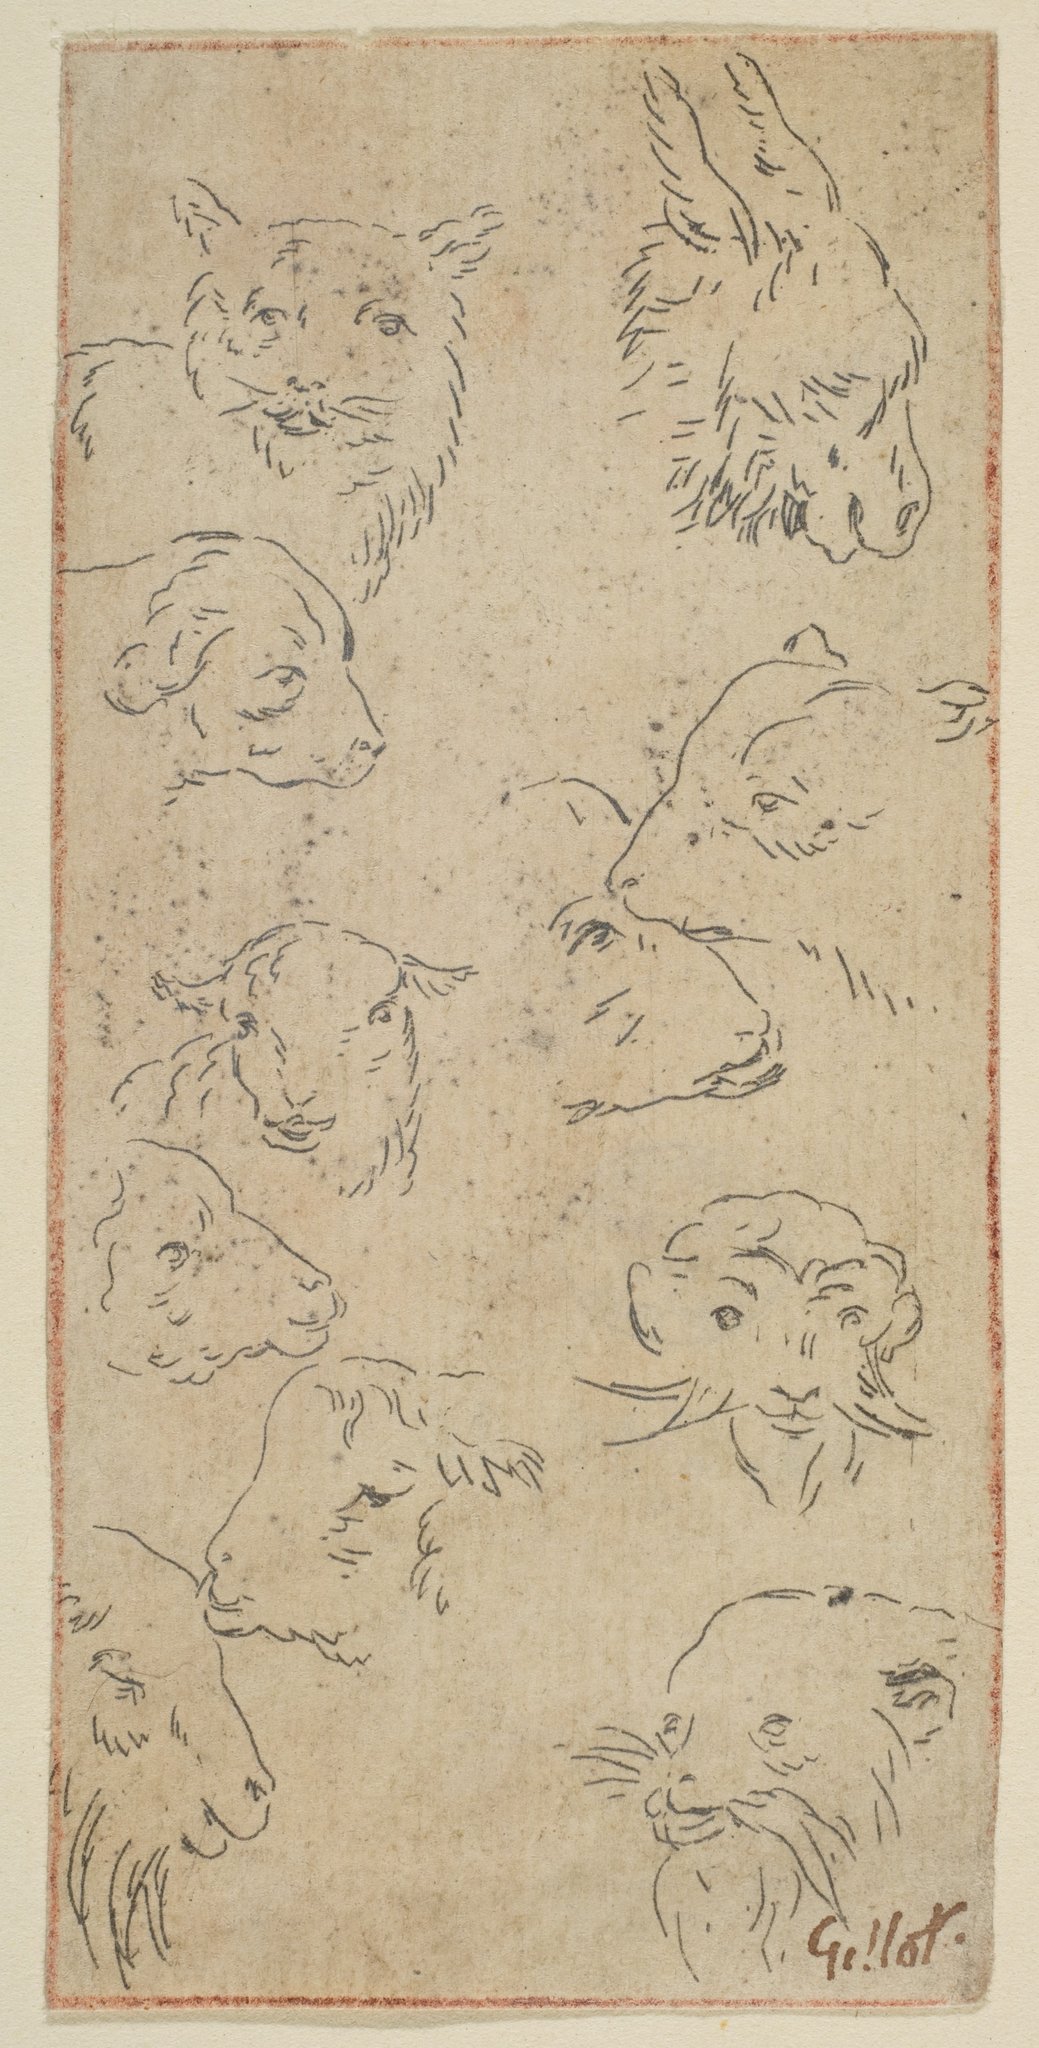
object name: print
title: Study of animal heads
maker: claude gillot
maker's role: artist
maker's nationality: french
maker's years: 1673-1722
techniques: engraving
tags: goats,sheep